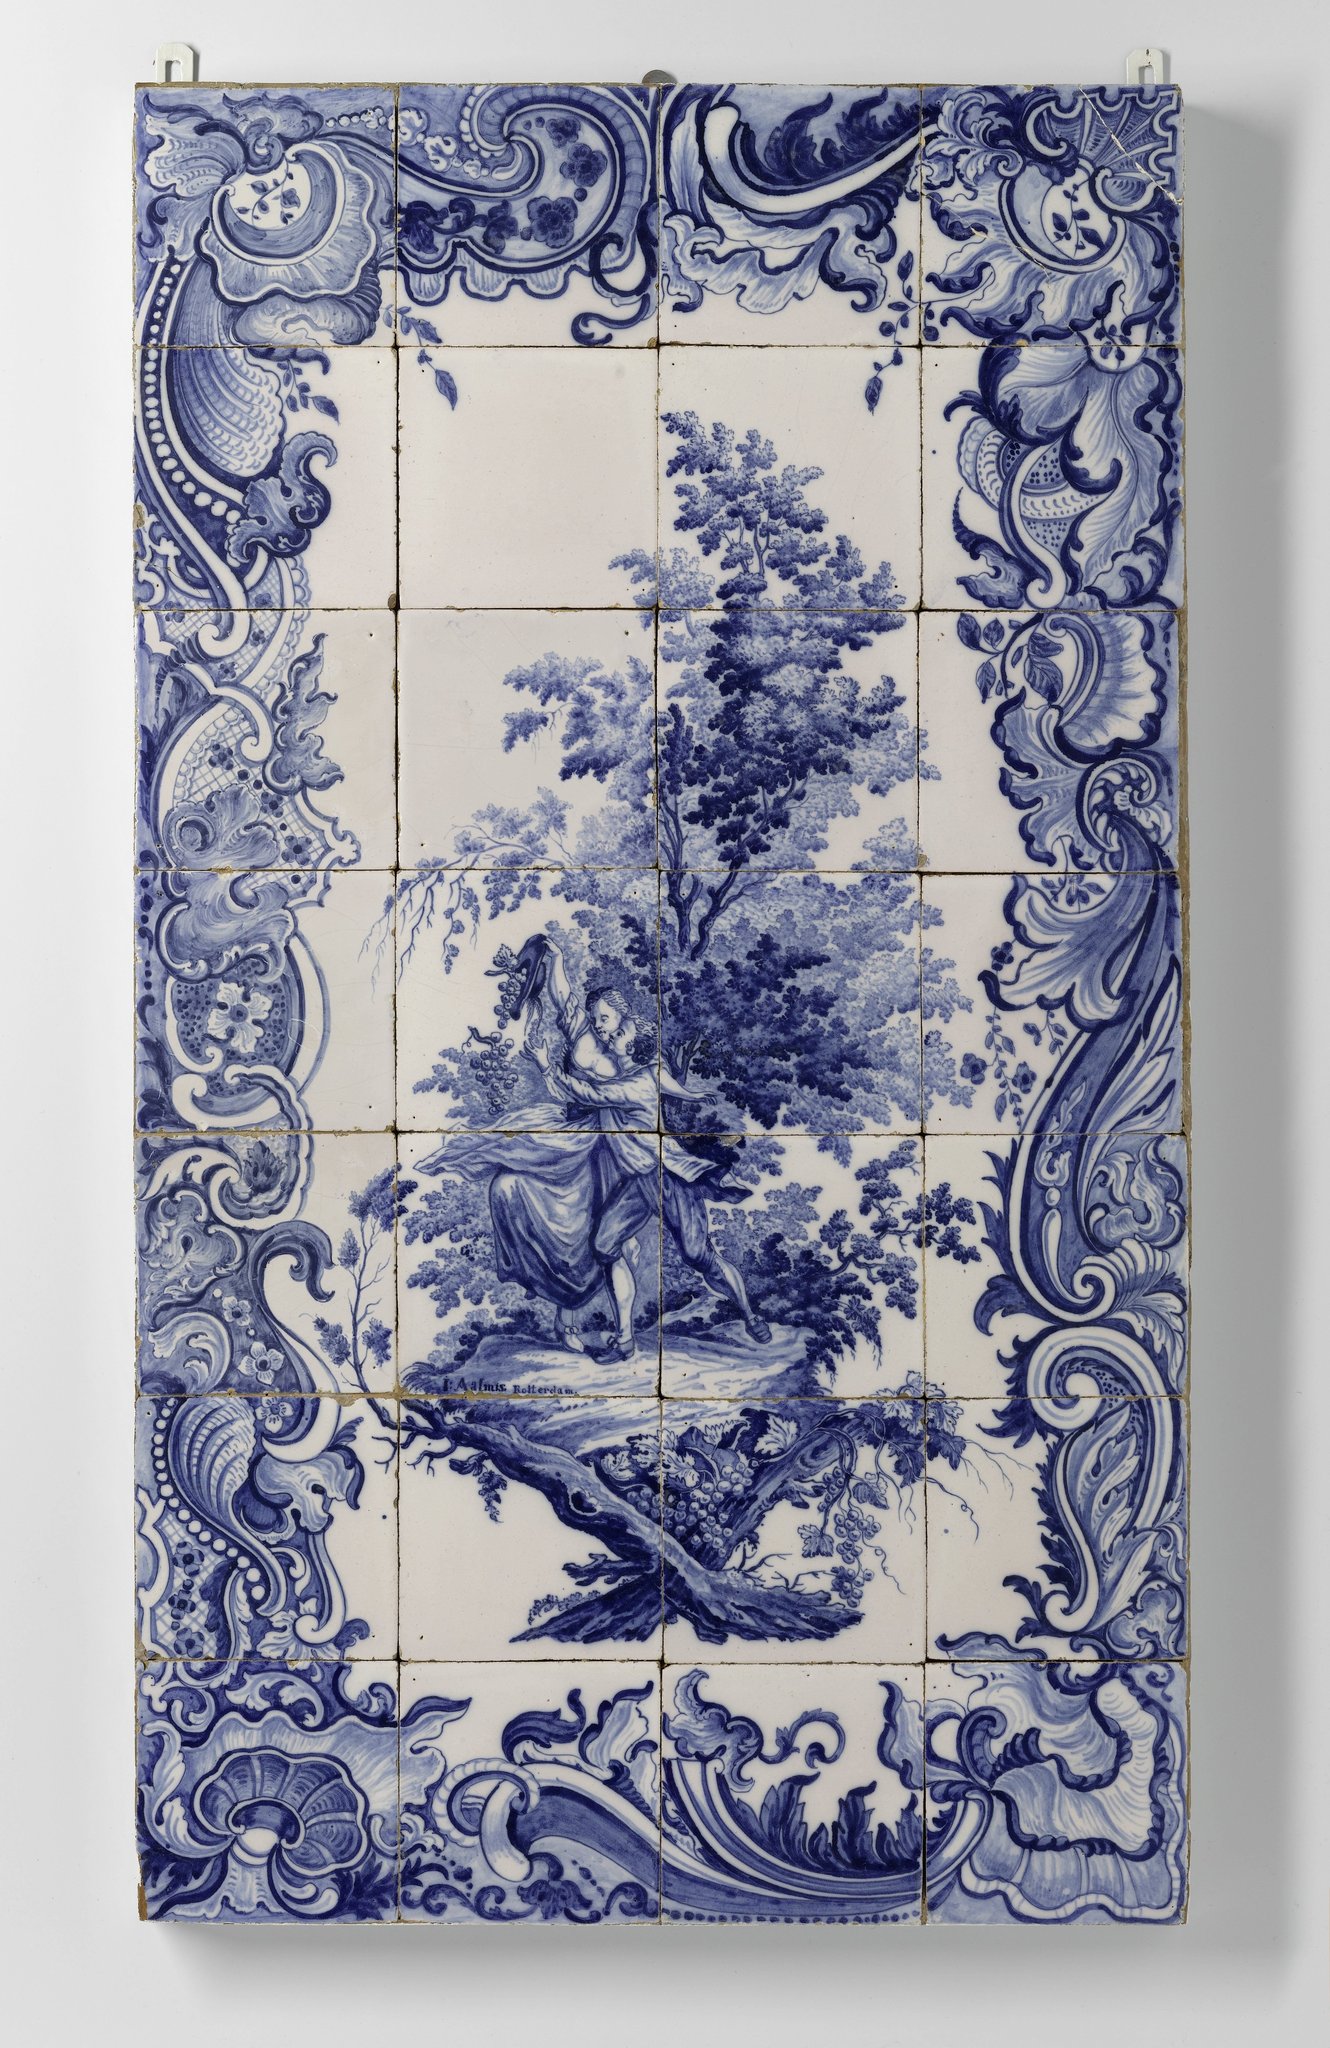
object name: tile tableau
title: Three tile panels with Autumn, Summer and Spring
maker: johannes aelmis (i)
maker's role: tegelschilder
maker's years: 1674-1755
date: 1760-1780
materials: earthenware, glaze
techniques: maiolica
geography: rotterdam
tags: one pair dancing; man and woman dancing as a couple, autumn ~ human activities (the four seasons of the year)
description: Couples with individual attributes represent three of the four seasons. An elegant, Rococo border frames the scenes. The panels probably come from a room once decorated with tiles.